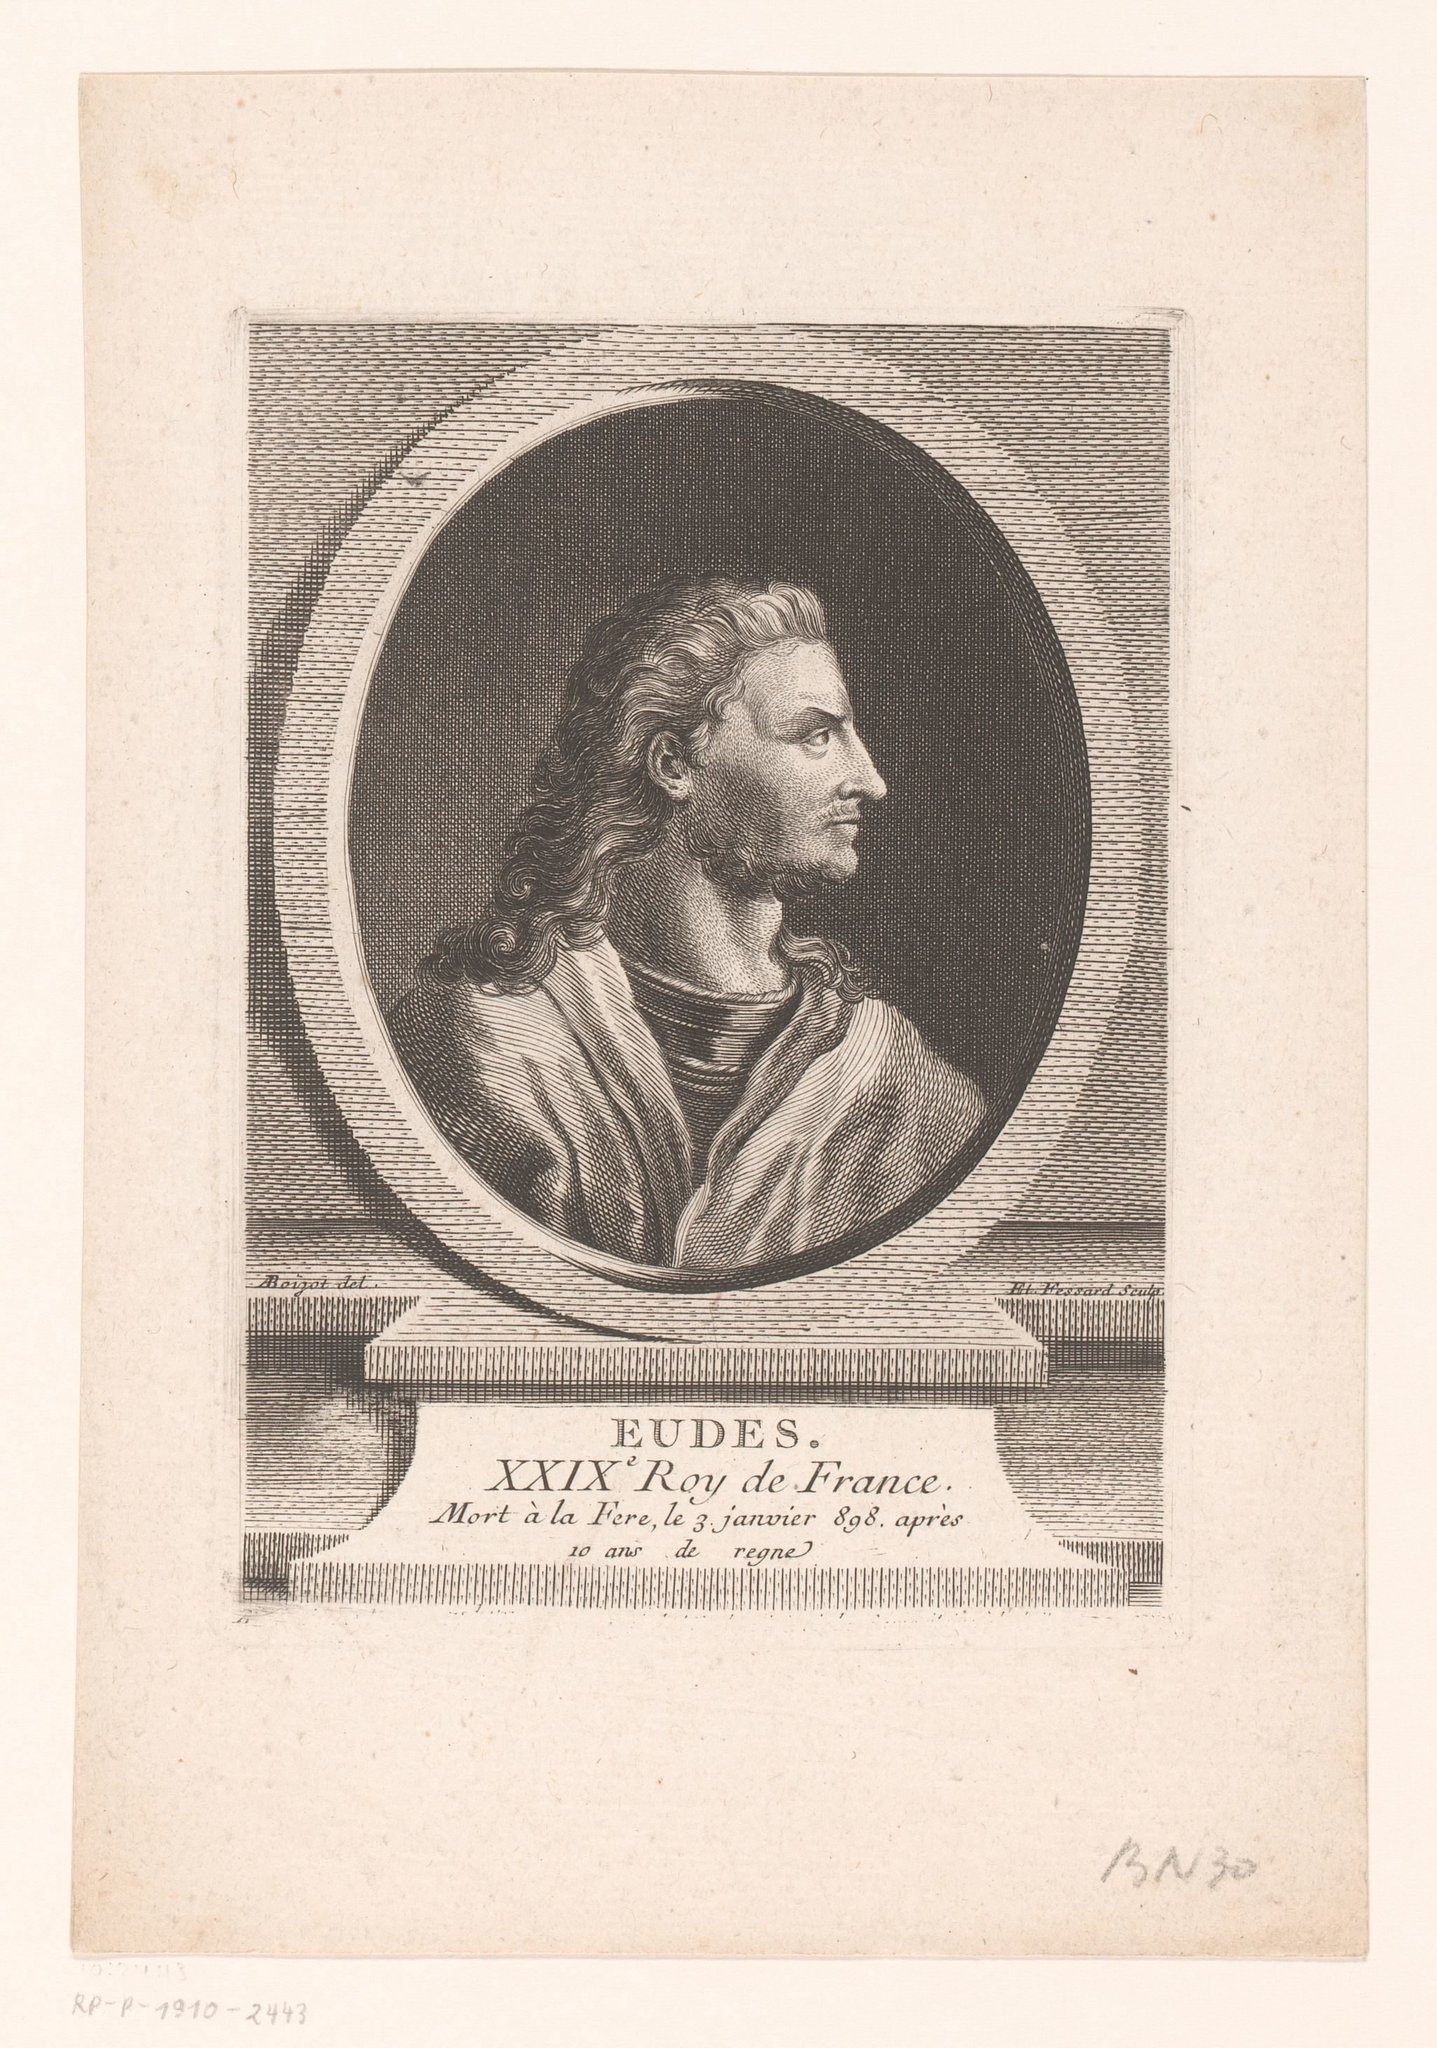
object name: print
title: Eudes. XXIXe Roi de France.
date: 1741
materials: paper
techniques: engraving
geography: france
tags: ornament ~ medallion, historical persons, ruler, sovereign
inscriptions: collector's mark: Lugt 2228